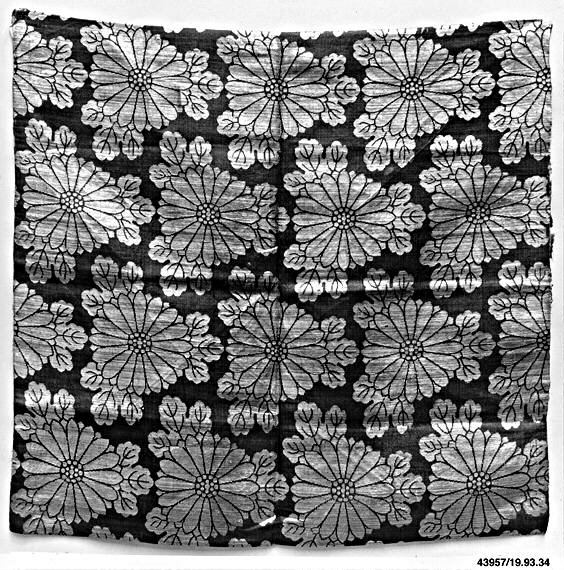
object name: altar cloth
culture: japanese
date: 1601-1800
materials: metal thread, silk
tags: flowers